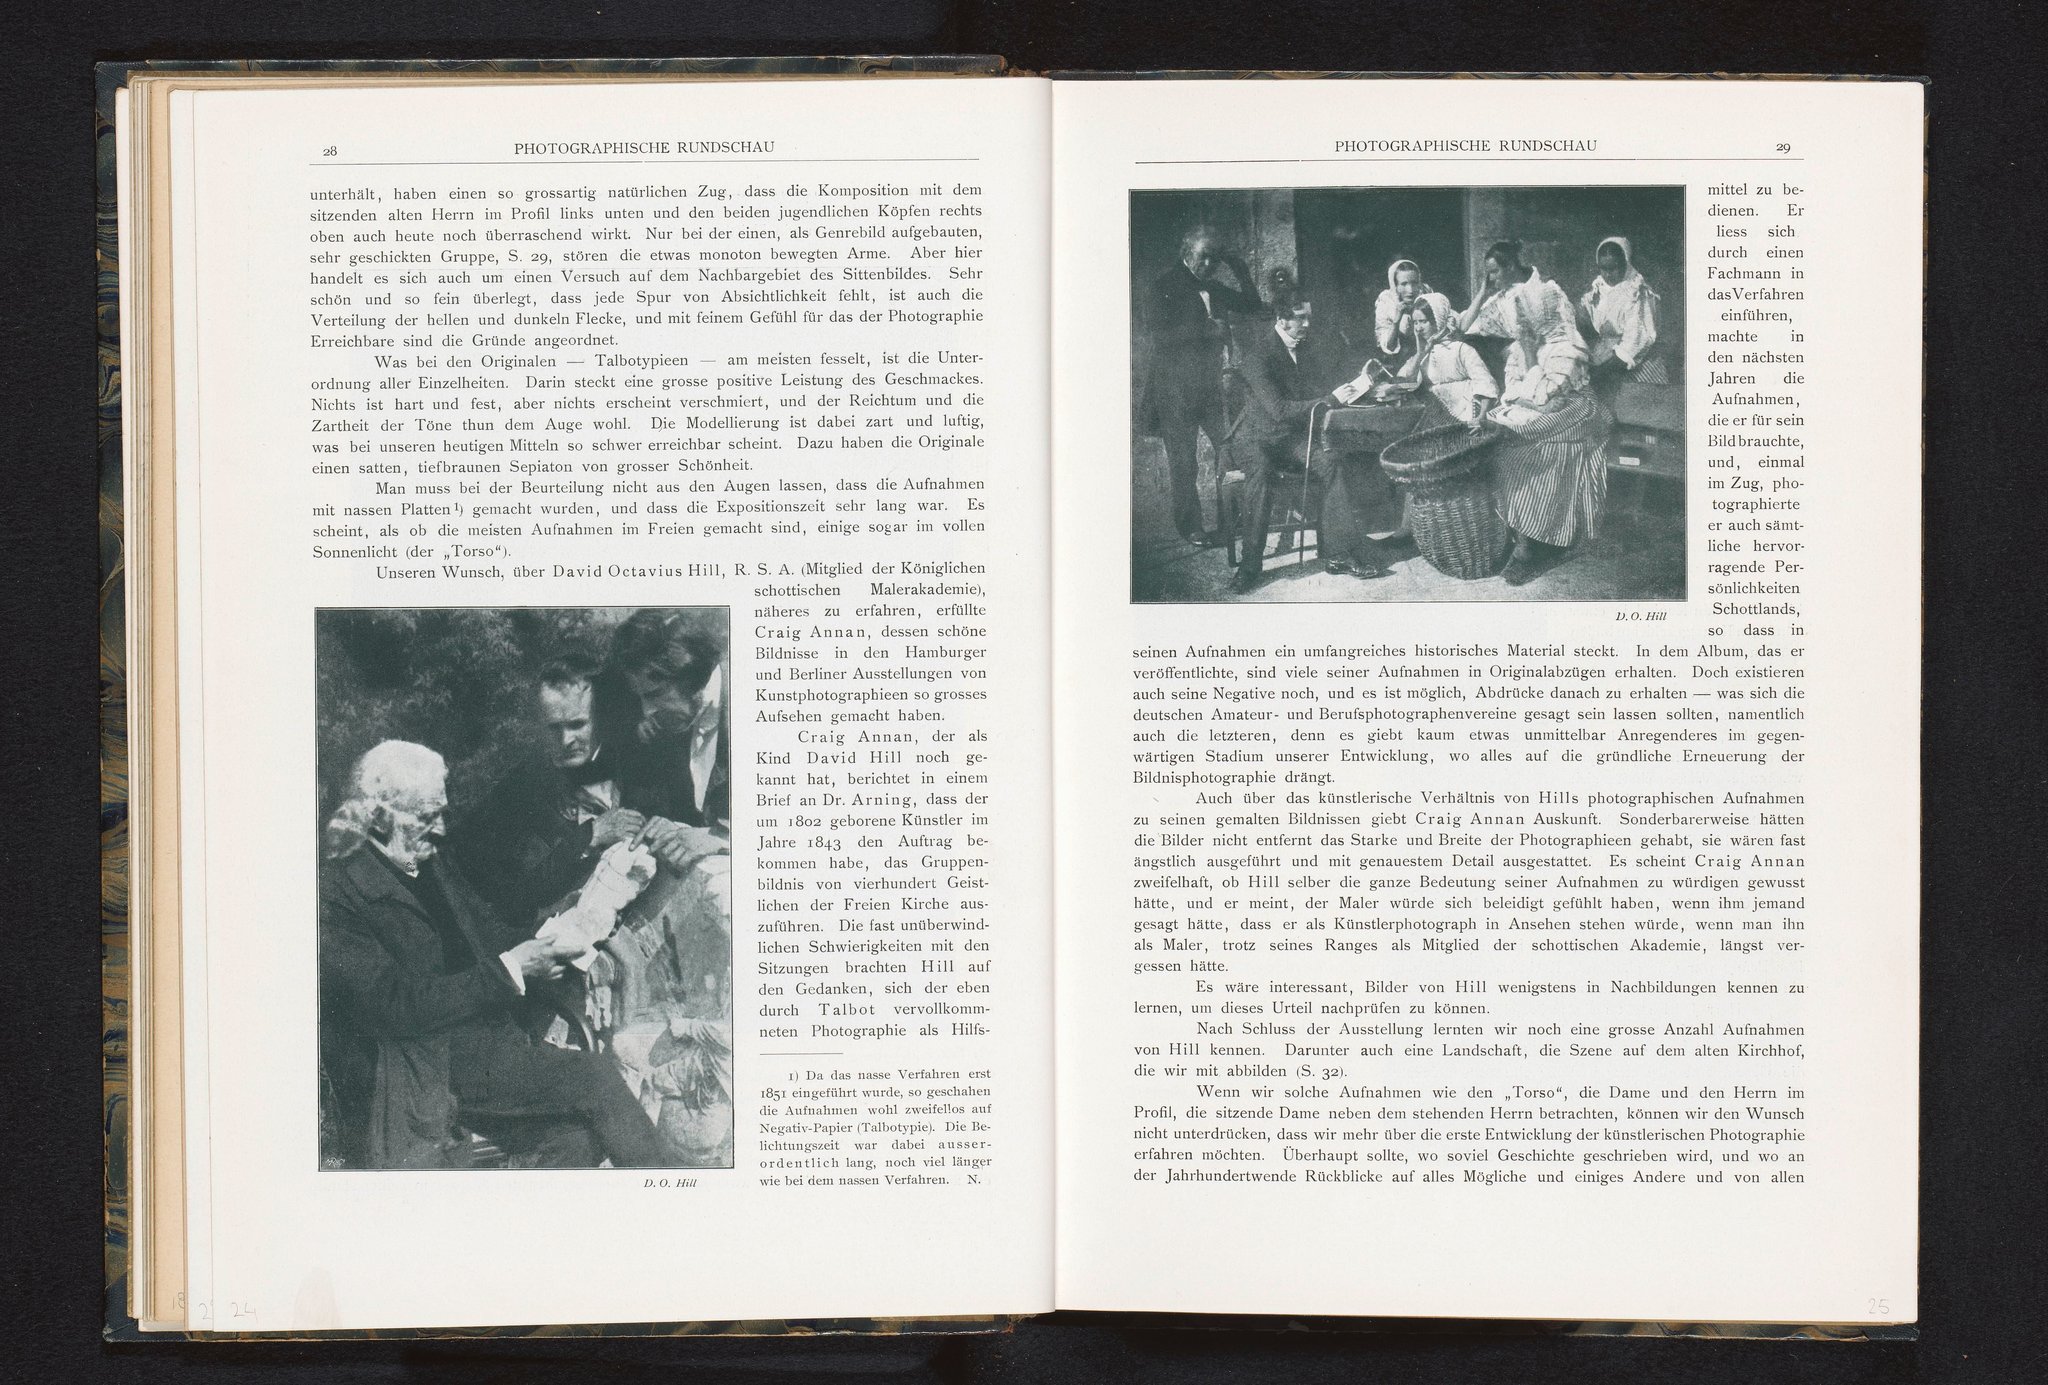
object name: page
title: Portret van drie onbekende mannen, waarvan één mogelijk David Octavius Hill, met een object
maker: david octavius hill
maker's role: fotograaf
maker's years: 1802-1870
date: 1895-1900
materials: paper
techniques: autotype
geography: berlin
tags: adult man, anonymous historical person portrayed